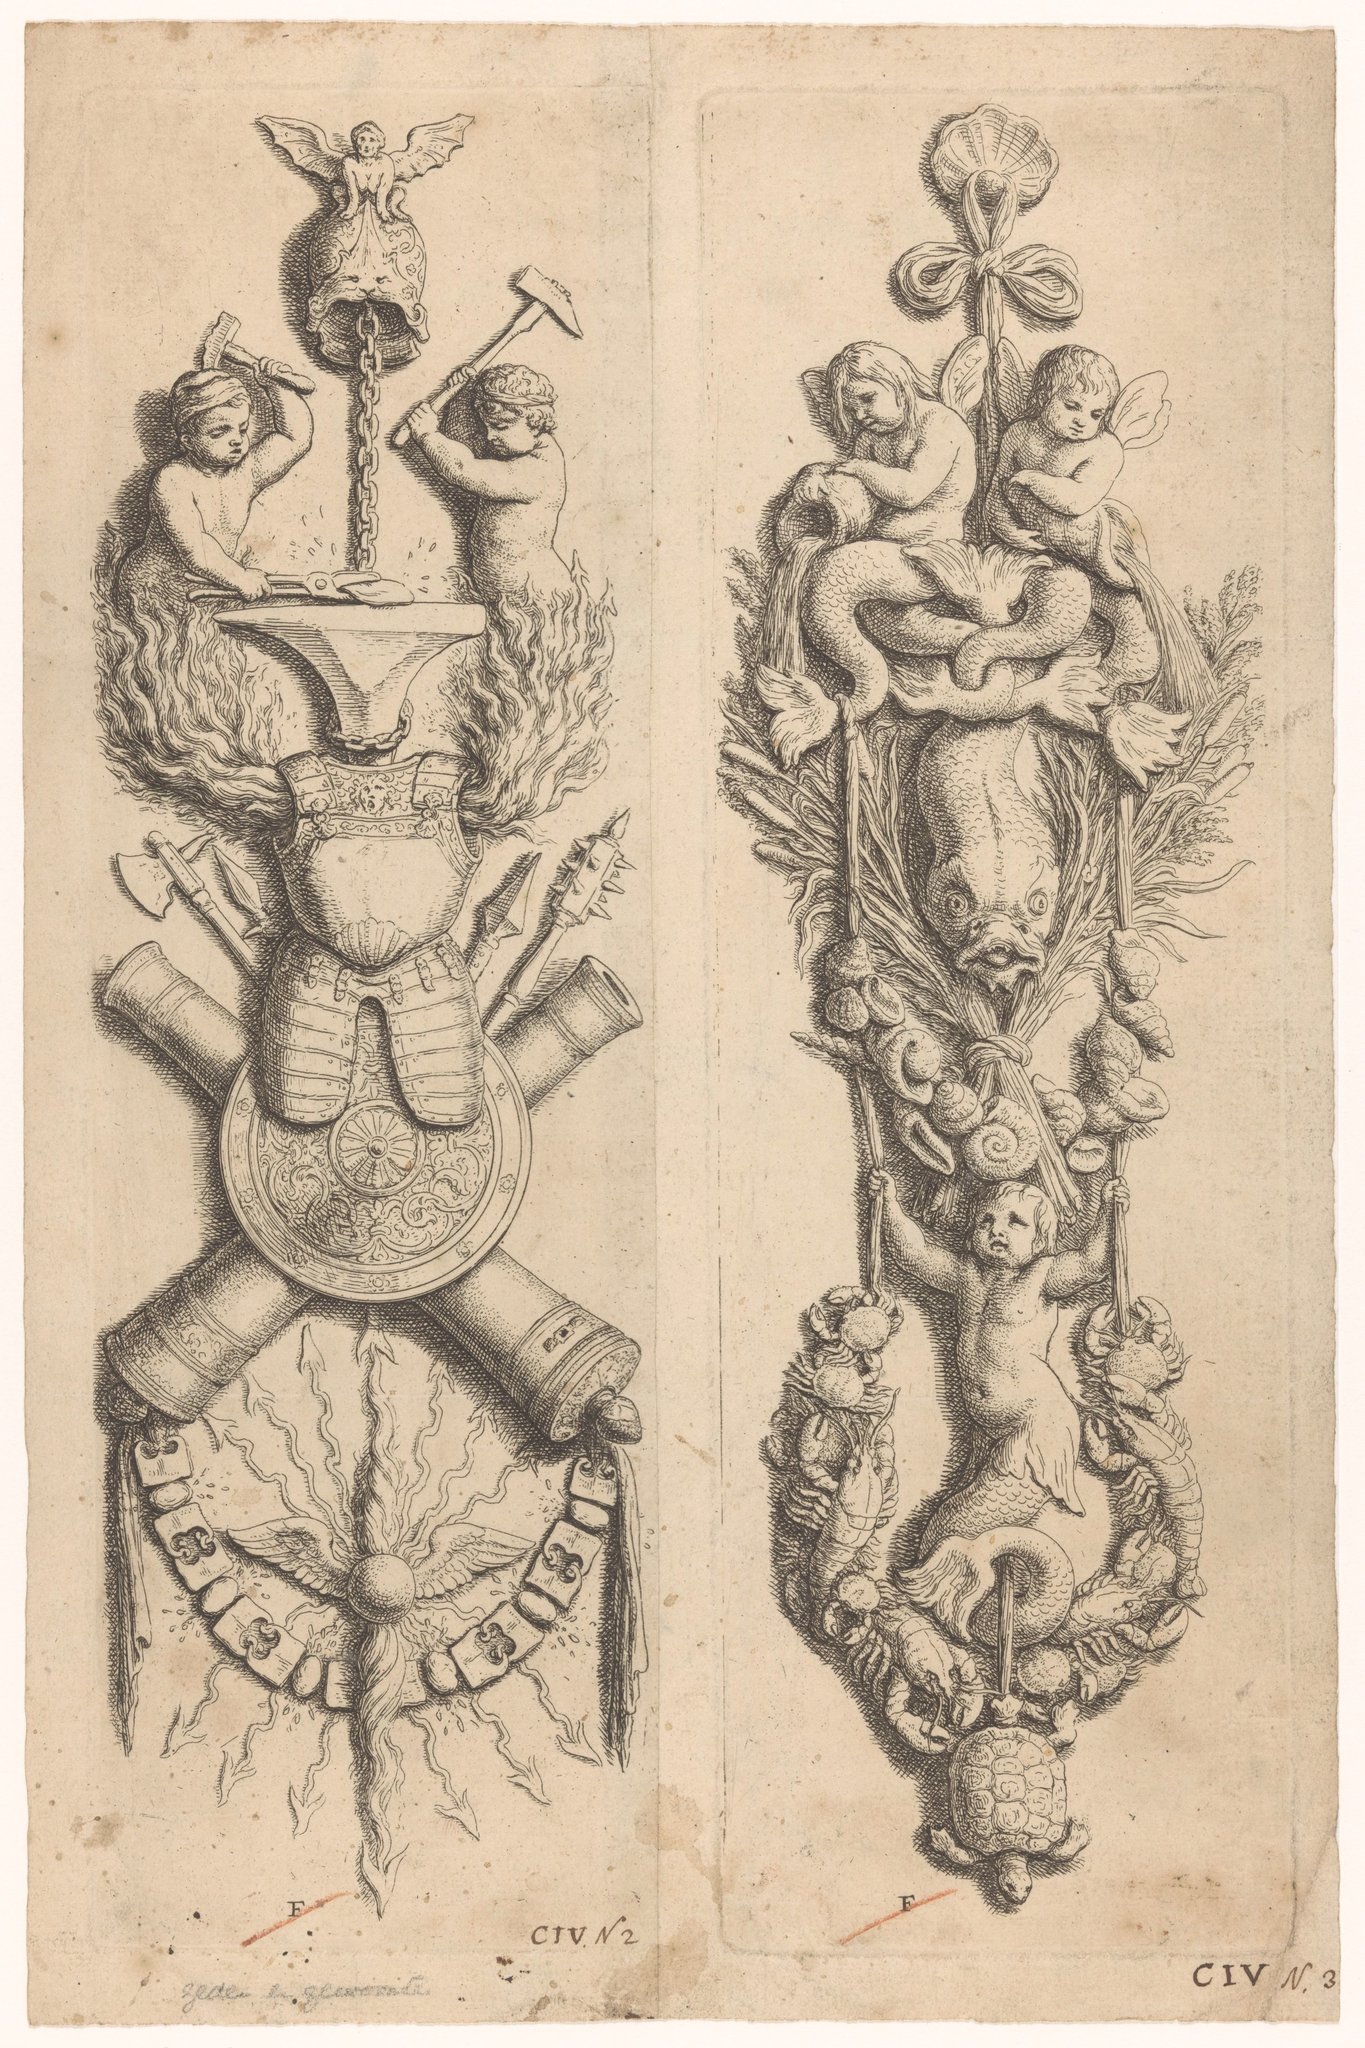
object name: ornament print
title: Secunda Pars Praecipuarum (...) /Het Tweede Deel Van de voornaemste Statuen ende Cieraten (...)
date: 1719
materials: paper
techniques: etching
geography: amsterdam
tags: trophy, i.e.: decorative arrangement of symbolic or typical objects ~ ornament, 'tropaion', i.e. decorative ornament ~ weapons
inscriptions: inscription: ‘CIV. N2’, inscription: ‘CIV N.3’, collector's mark: Lugt 2233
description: Twee prenten op een blad. Links een wapentrofee met smedende halffiguren in vuur aan weerszijden van een aambeeld. Rechts een trofee met meermannen, een vis en schaaldieren. Midden onder F genummerd.